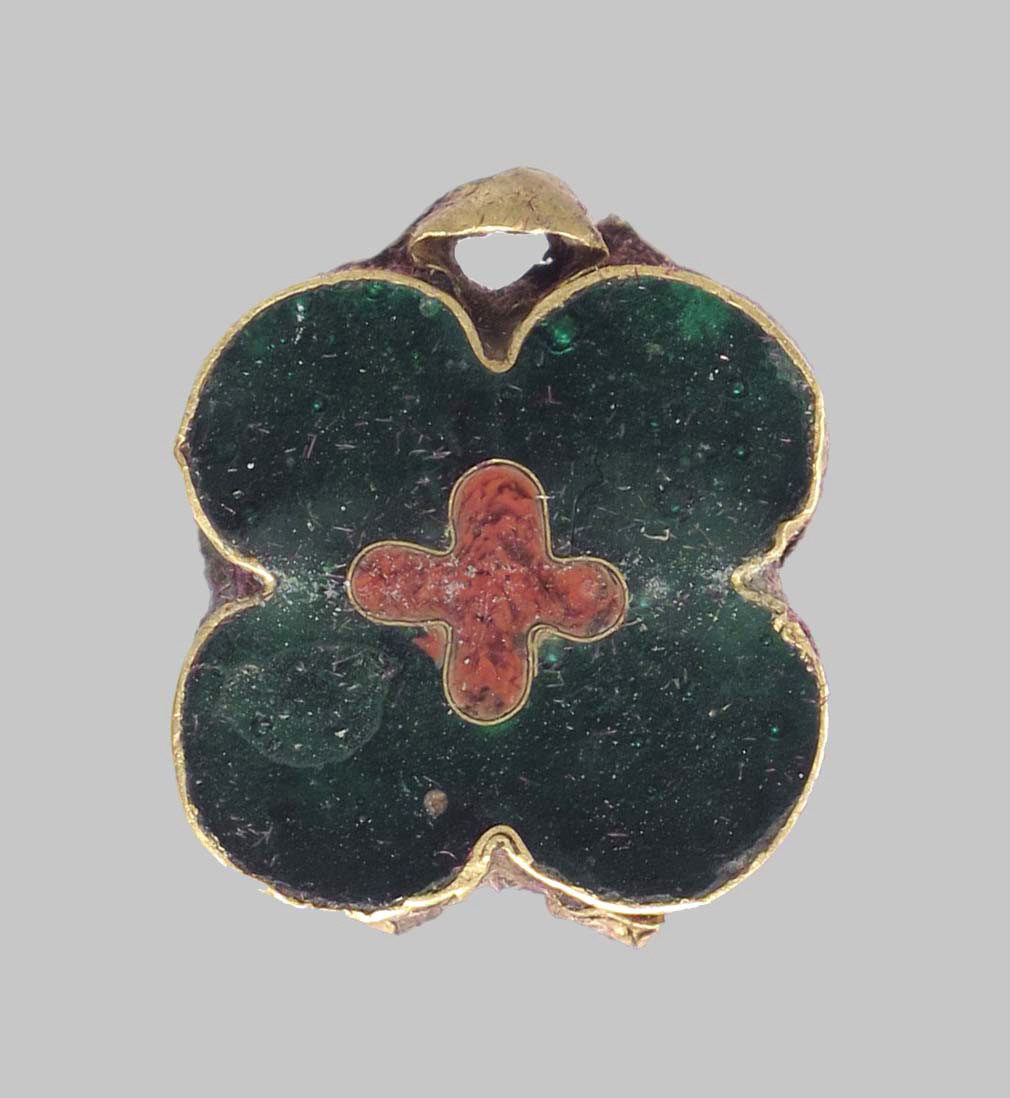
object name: enamel fragment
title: Fragment of a Flower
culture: french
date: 1001-1100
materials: enamel, gold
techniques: enamel